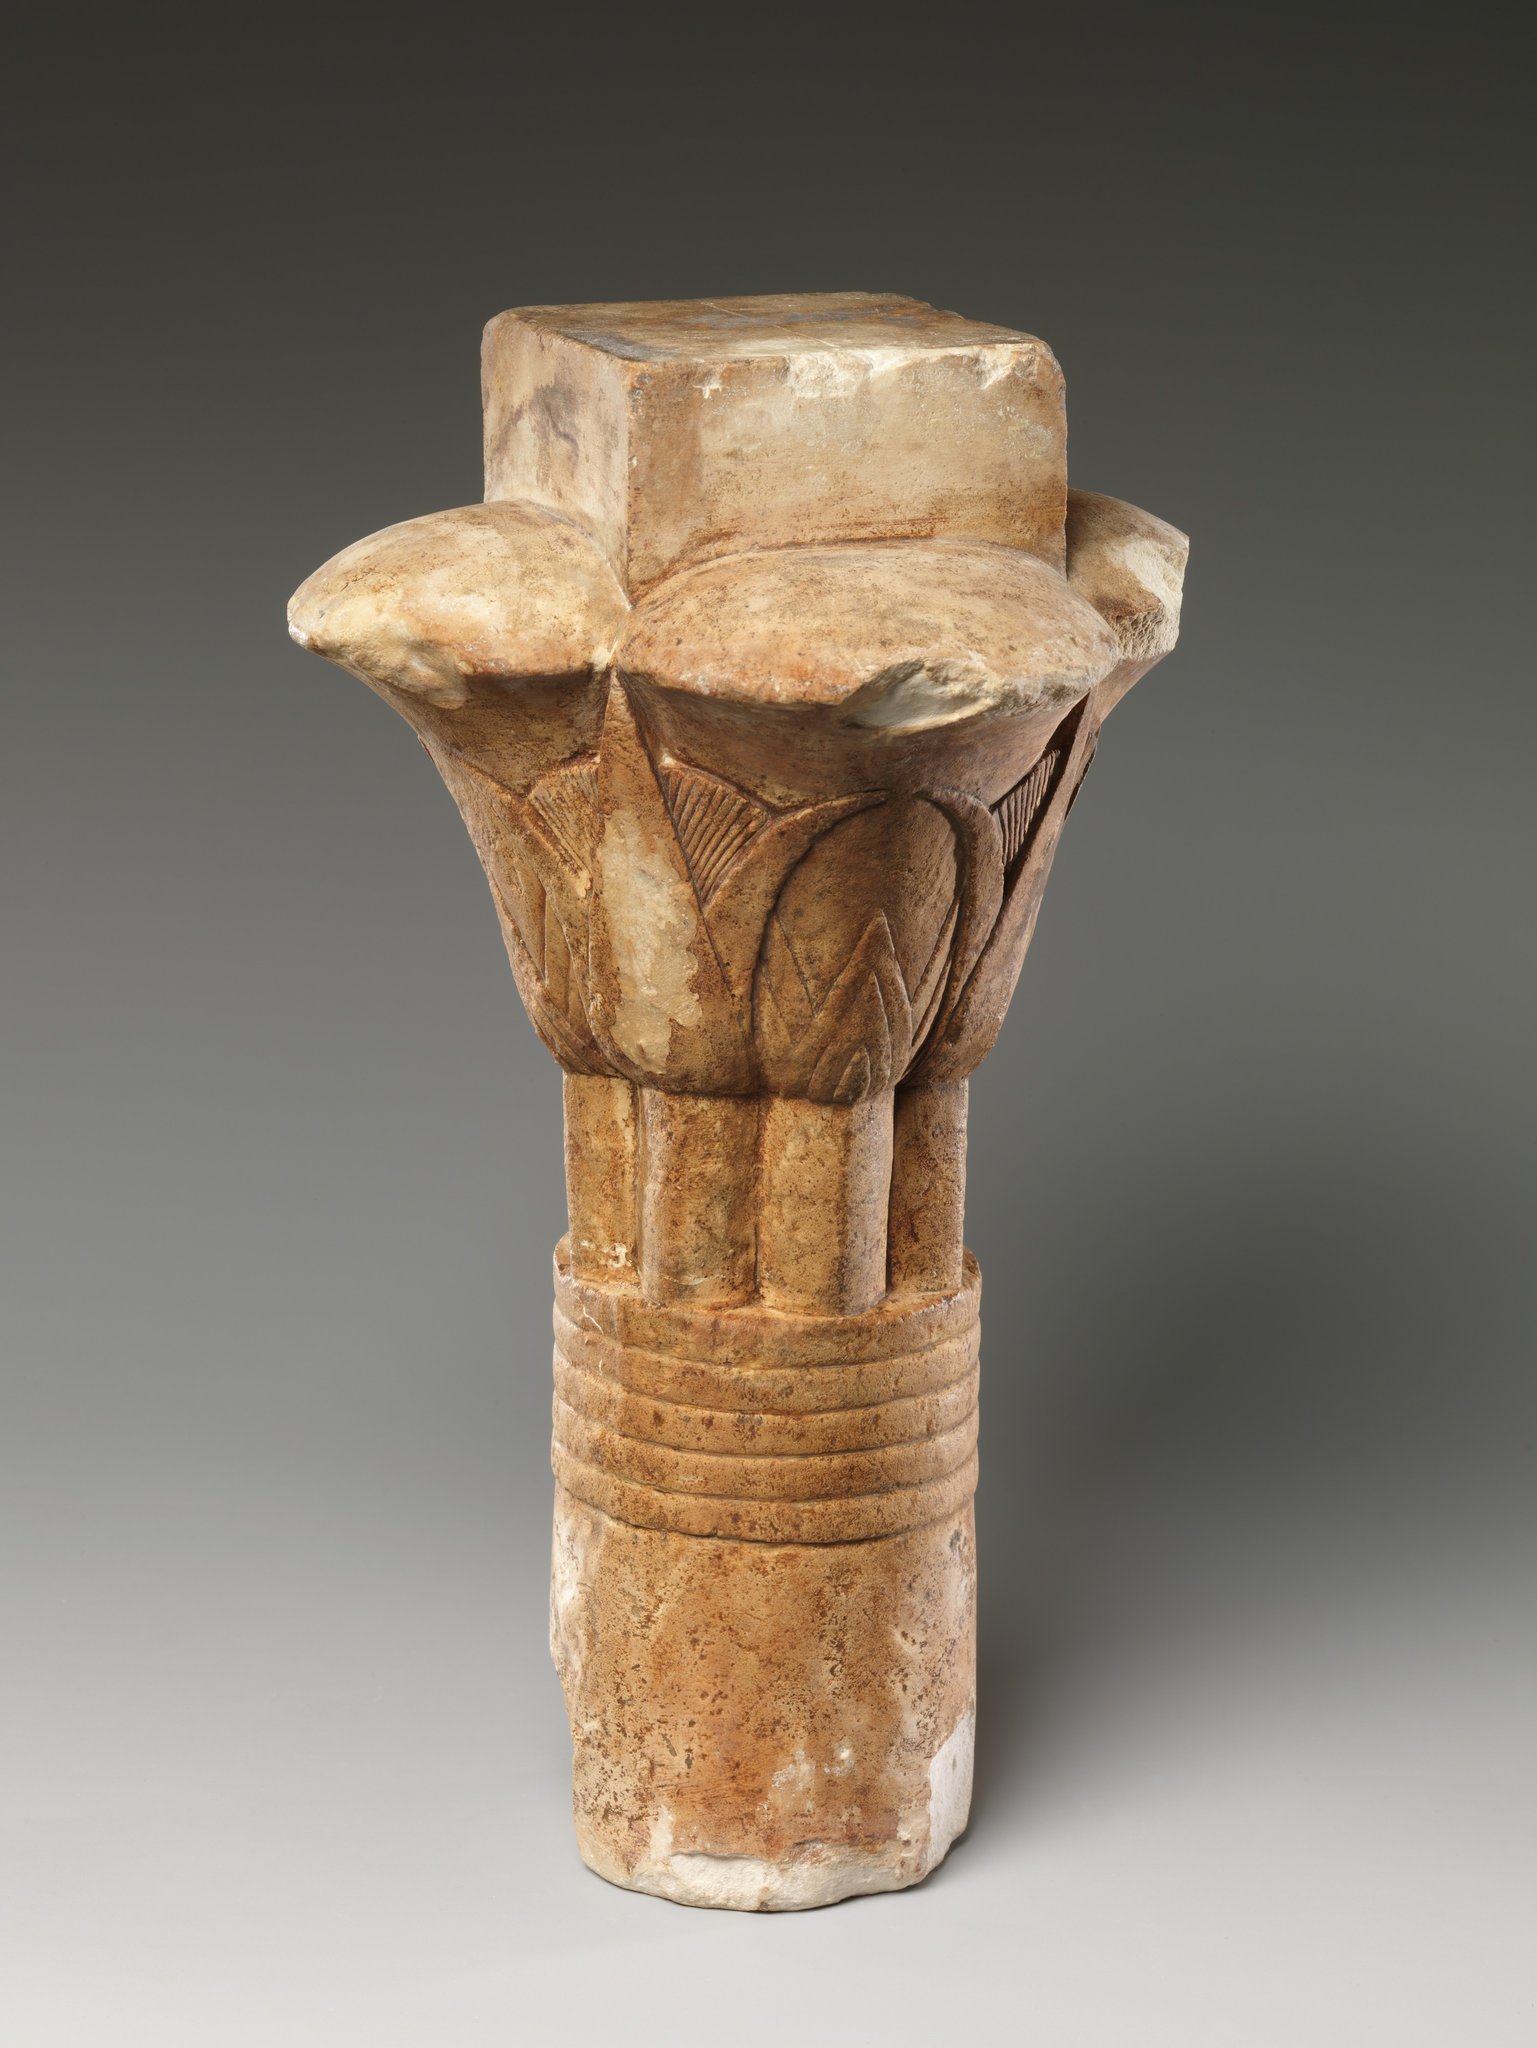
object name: sculptor's model votive, palmette capital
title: Model quatrefoil palmette capital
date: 400-30 BCE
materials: limestone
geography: egypt